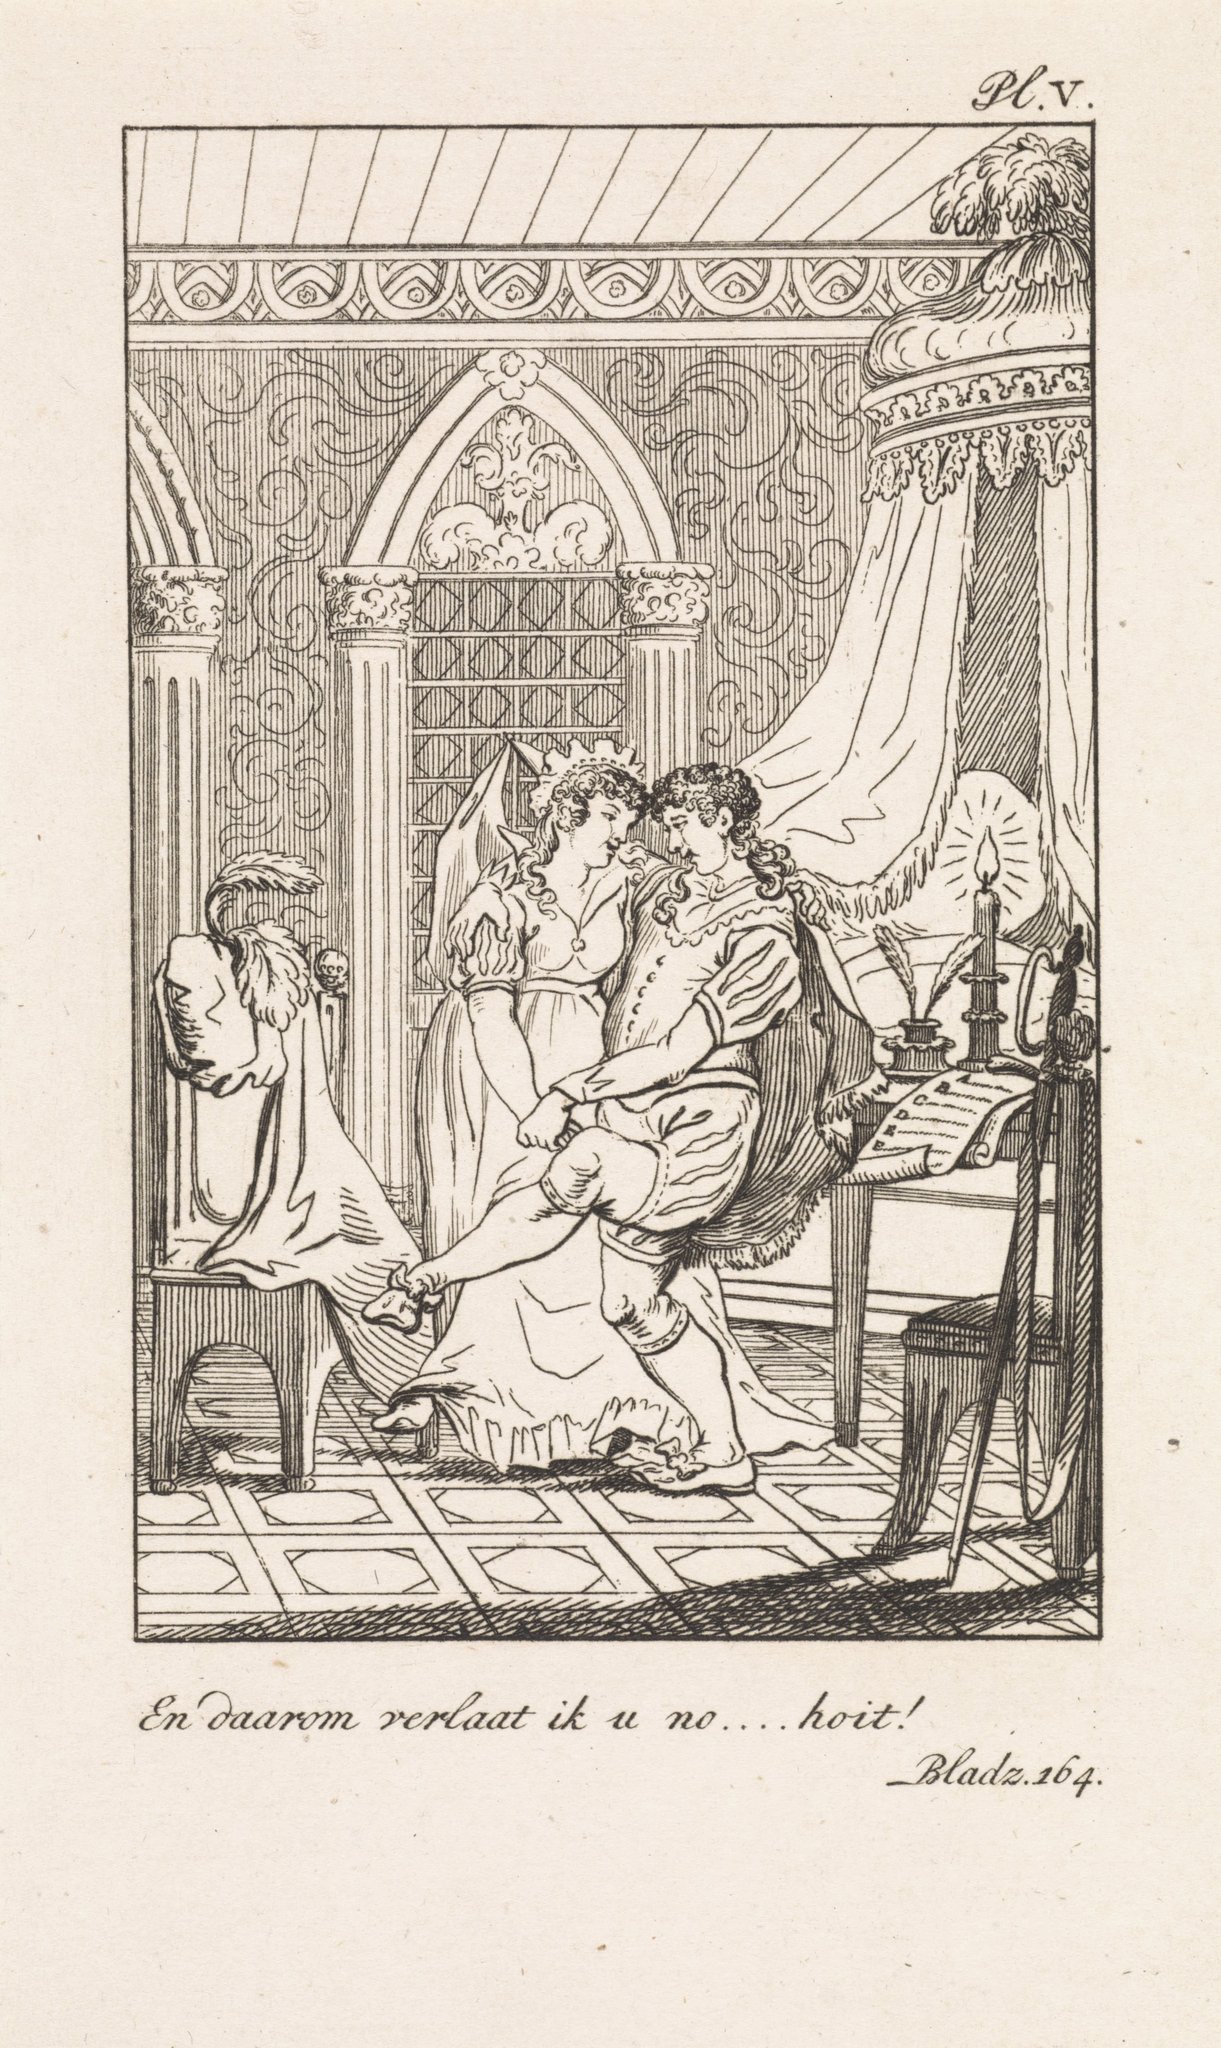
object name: print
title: En daarom verlaat ik u n (...).hoit!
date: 1802-1809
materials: paper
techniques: etching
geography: haarlem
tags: couple of lovers, bedroom, political caricatures and satires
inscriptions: collector's mark: Lugt 2228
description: Prent als boekillustratie gebruikt in: Fokke Simonsz., Arend. Het hoekjen van den haard of Historie van Frankrijk. Deel IV-VII uit: Boertige Reis door Europa. 7 dln. Haarlem: François Bohn, 1802-1809.